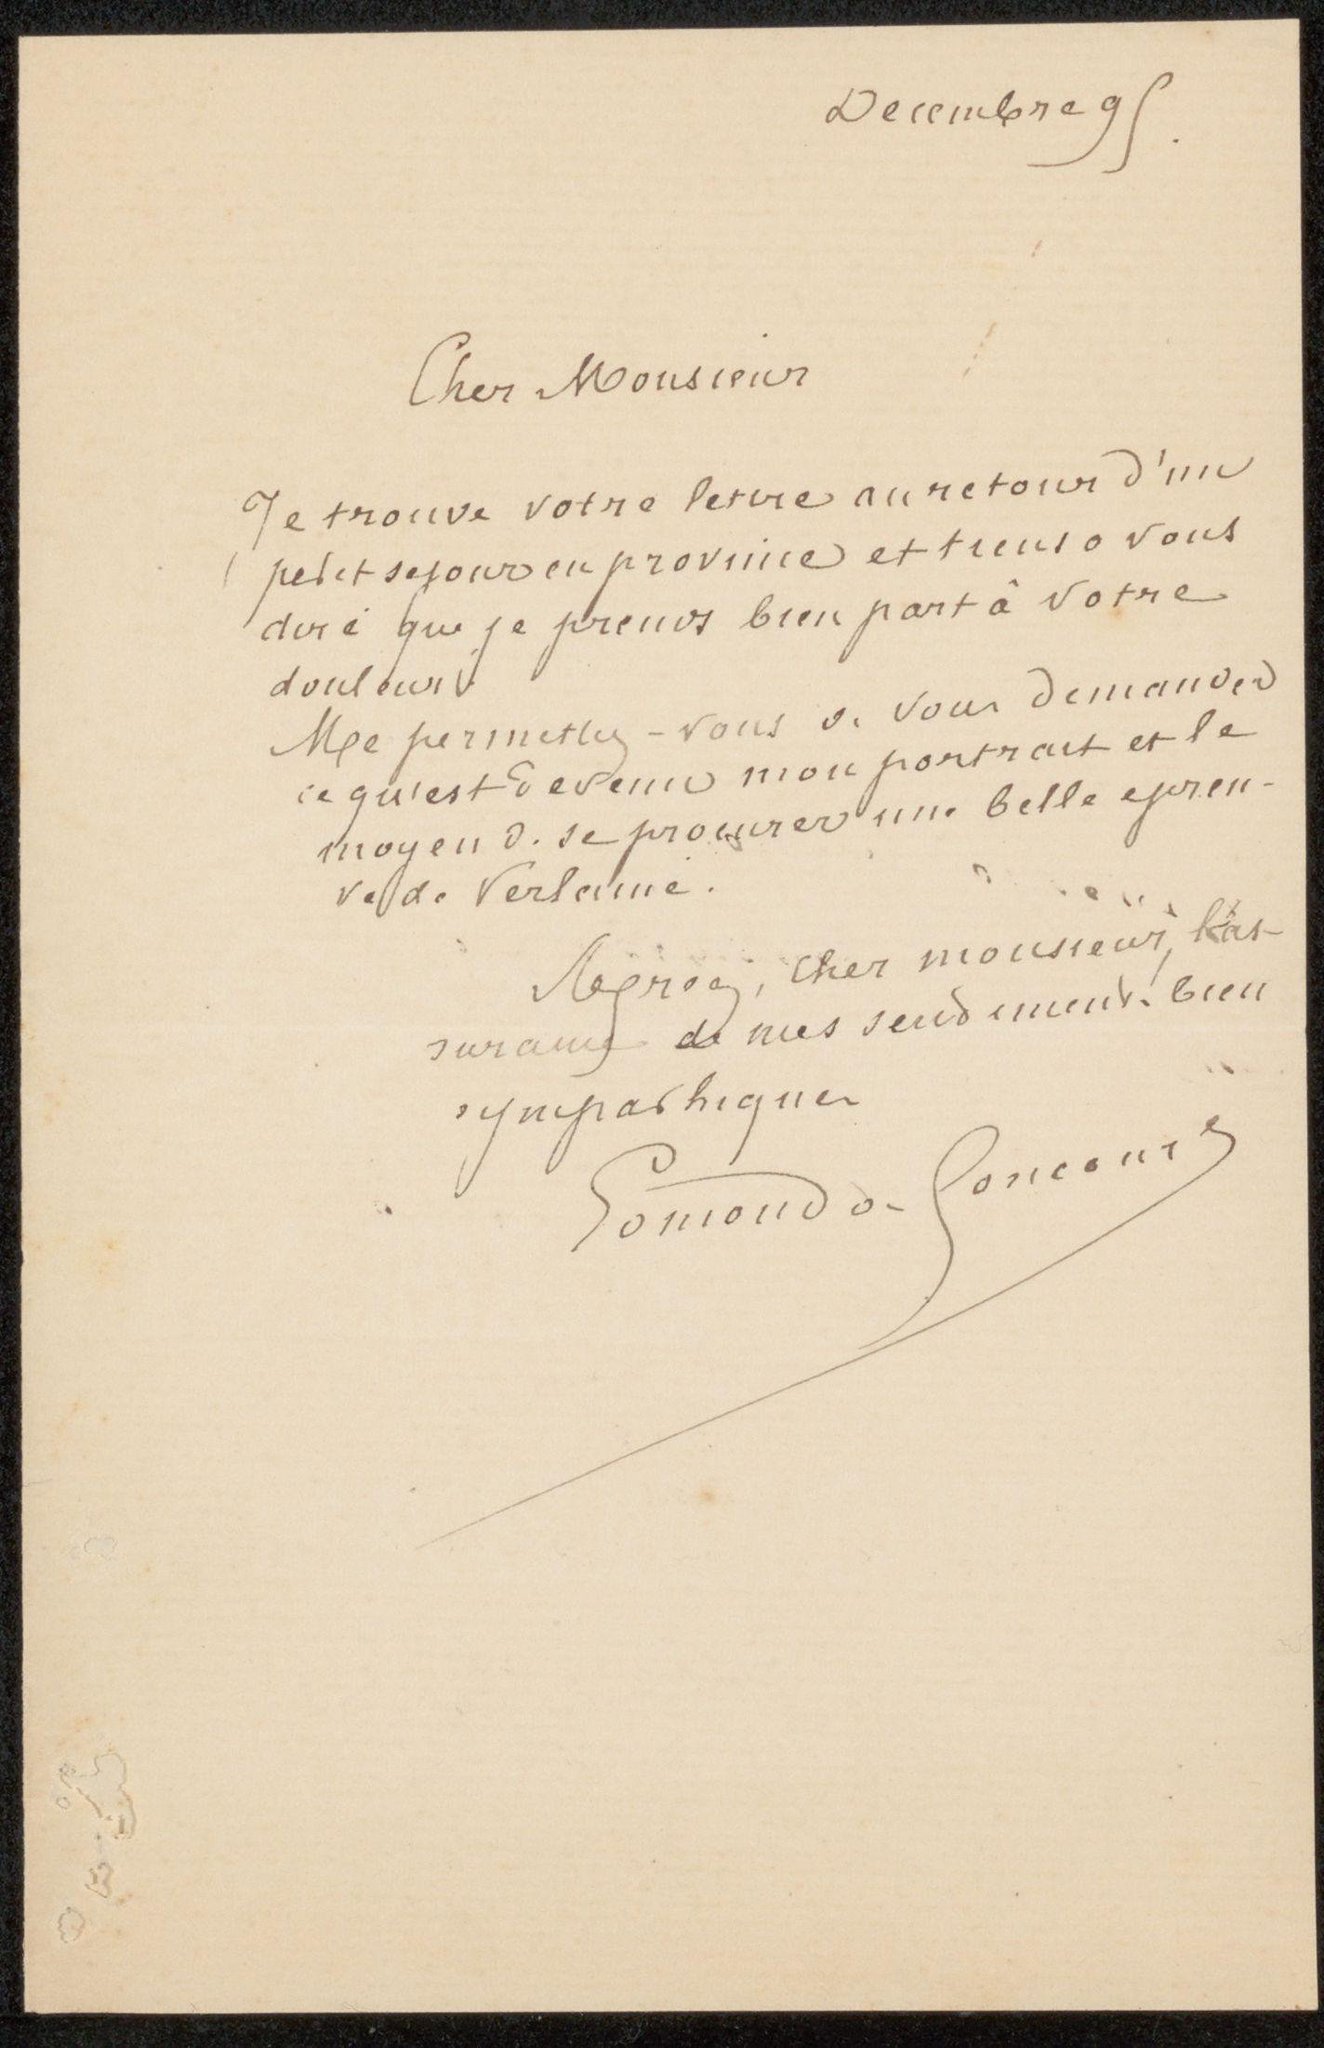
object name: letter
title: Brief aan Philip Zilcken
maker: edmond de goncourt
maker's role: draughtsman, painter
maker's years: 1822-1896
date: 1895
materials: ink, paper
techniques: pen, writing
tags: paris, paul verlaine, helène lambertine hauzeur, the hague, philip zilcken, passions, emotions, affections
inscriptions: watermark